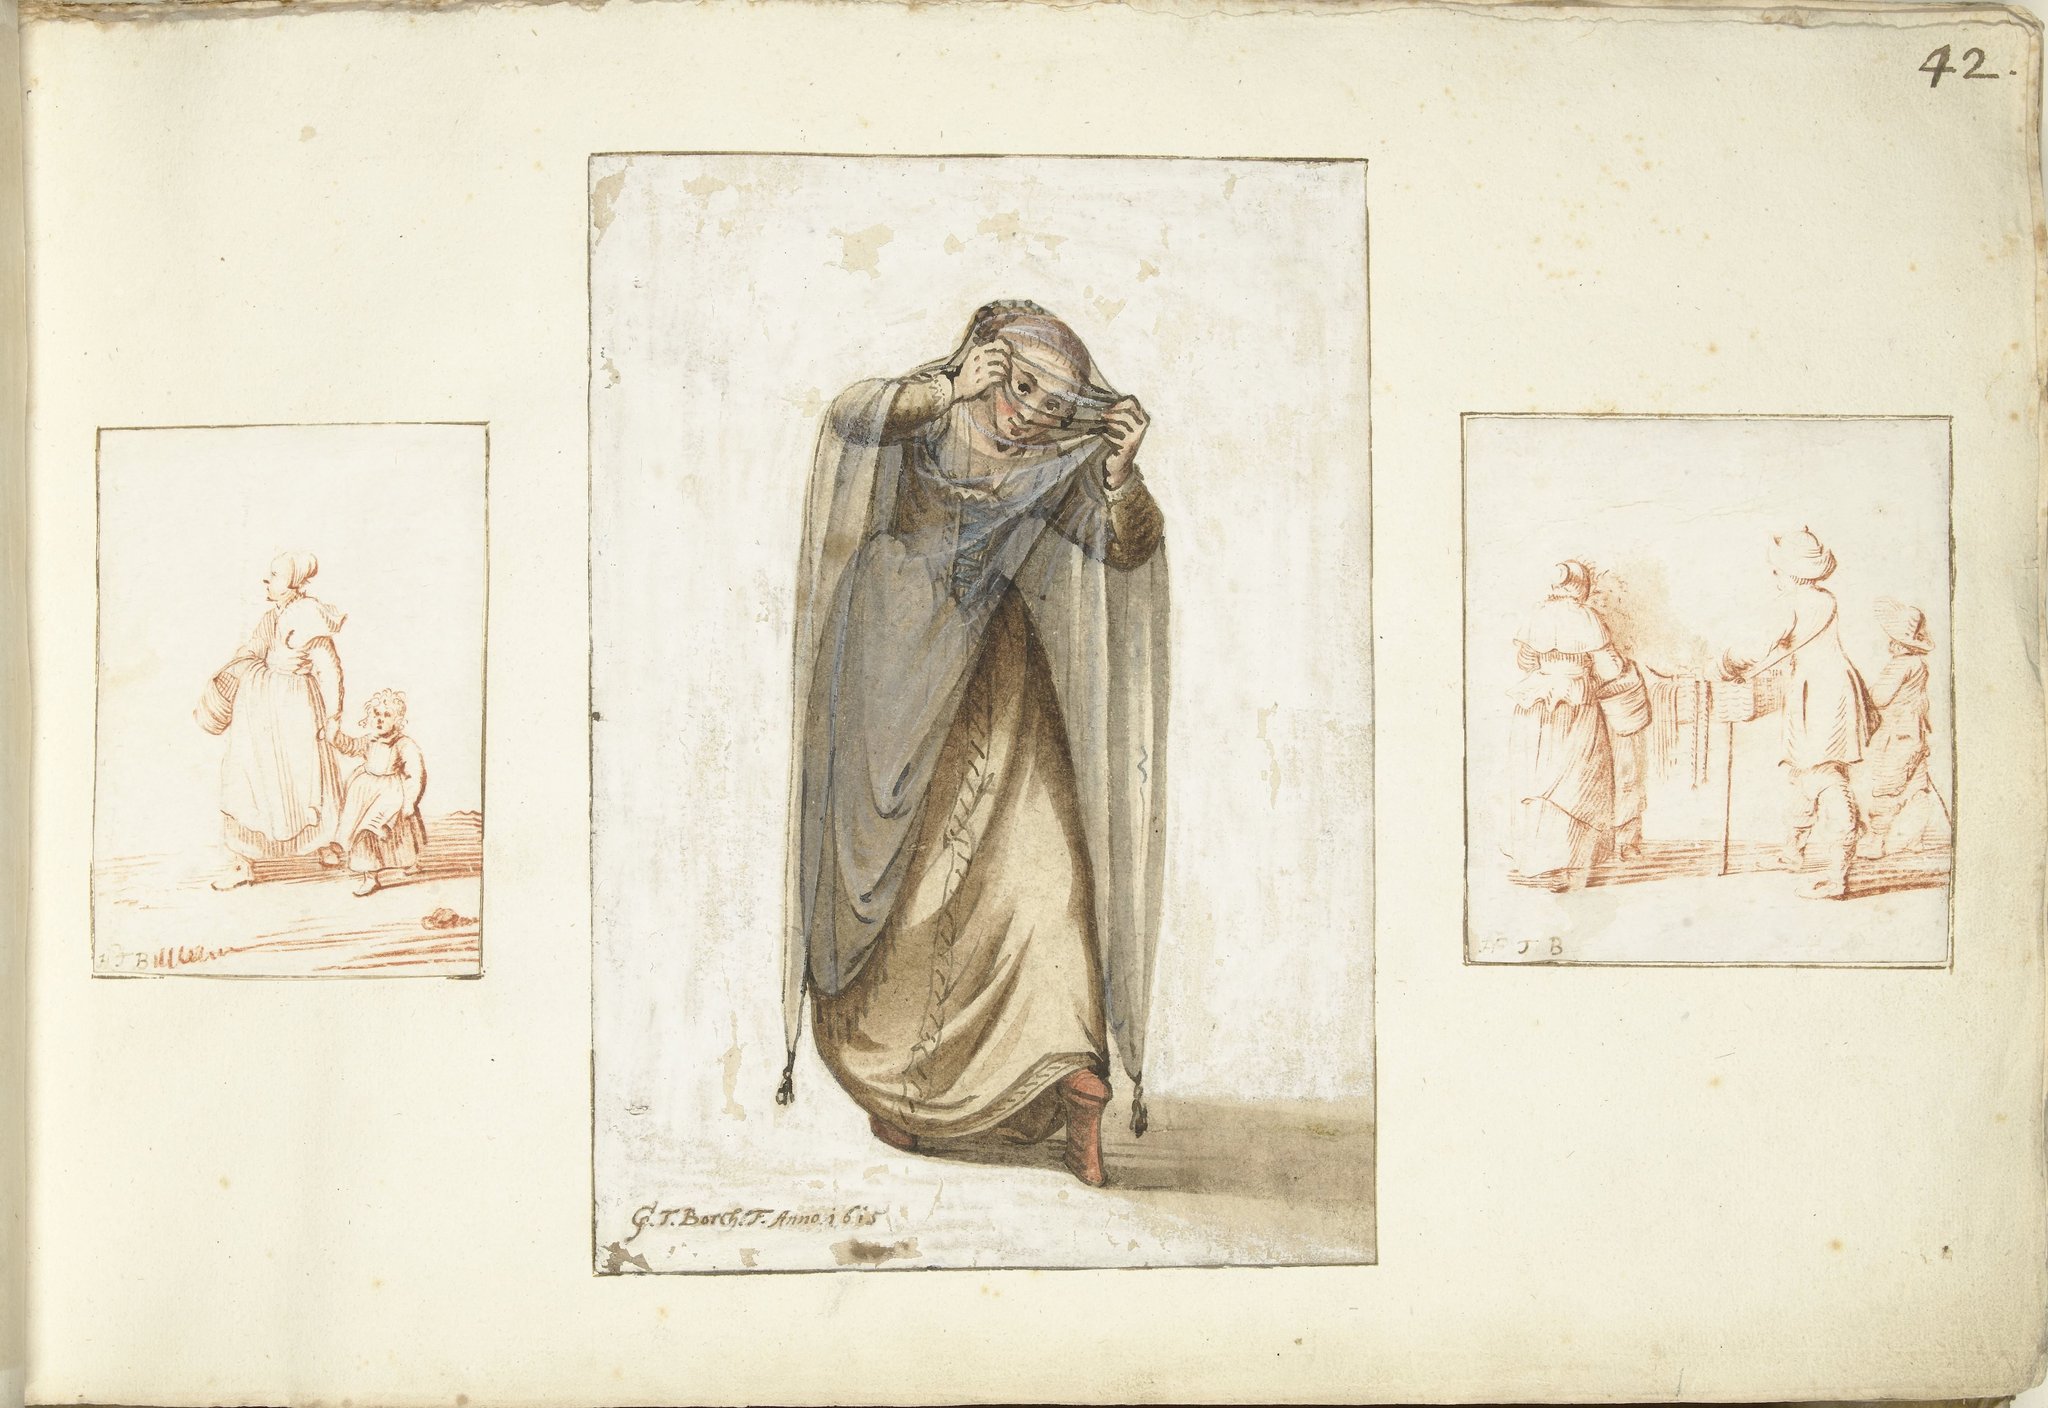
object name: drawing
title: Vrouw met kind, een courtisane en een marskramer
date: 1660-1687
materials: chalk, paint, paper, watercolor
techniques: brush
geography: zwolle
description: Drie opgeplakte tekeningen, twee van Harmen en een van Gerard de Oude.